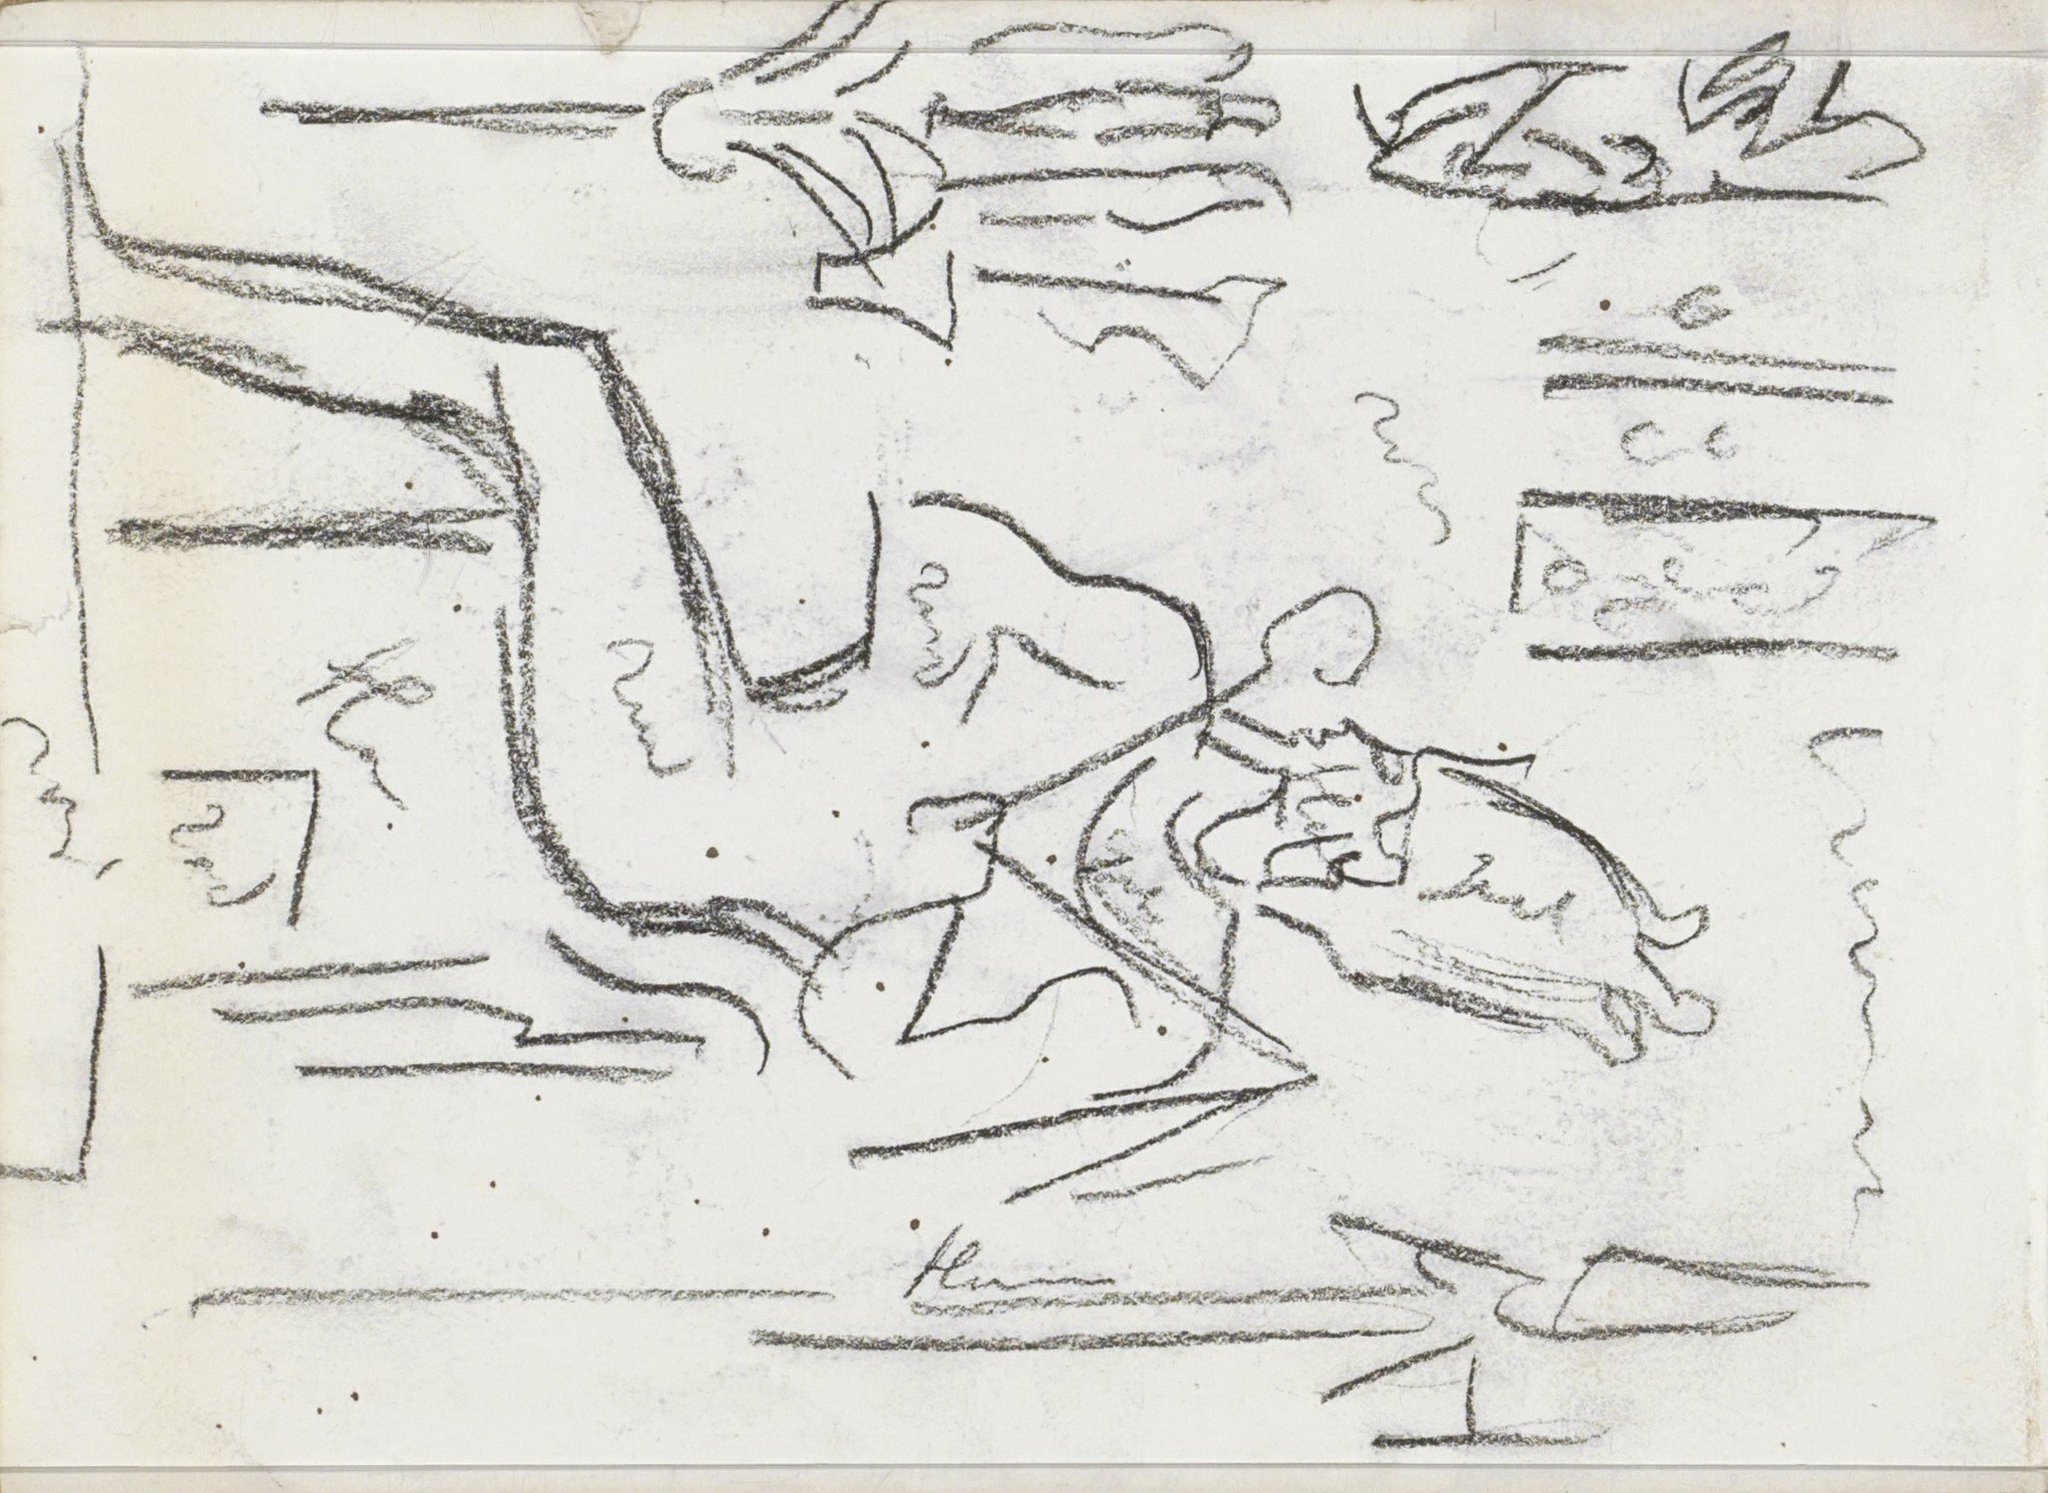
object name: sketchbook leaf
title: Egyptisch reliëf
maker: marius bauer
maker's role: draughtsman, print maker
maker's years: 1867-1932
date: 1919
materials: chalk, paper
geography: egypt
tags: art (+ relief ~ sculpture)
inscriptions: kleurnotitie, handgeschreven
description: Vermoedelijk een reliëf uit een tempelinterieur. Pagina 2 uit een schetsboek met 23 bladen.